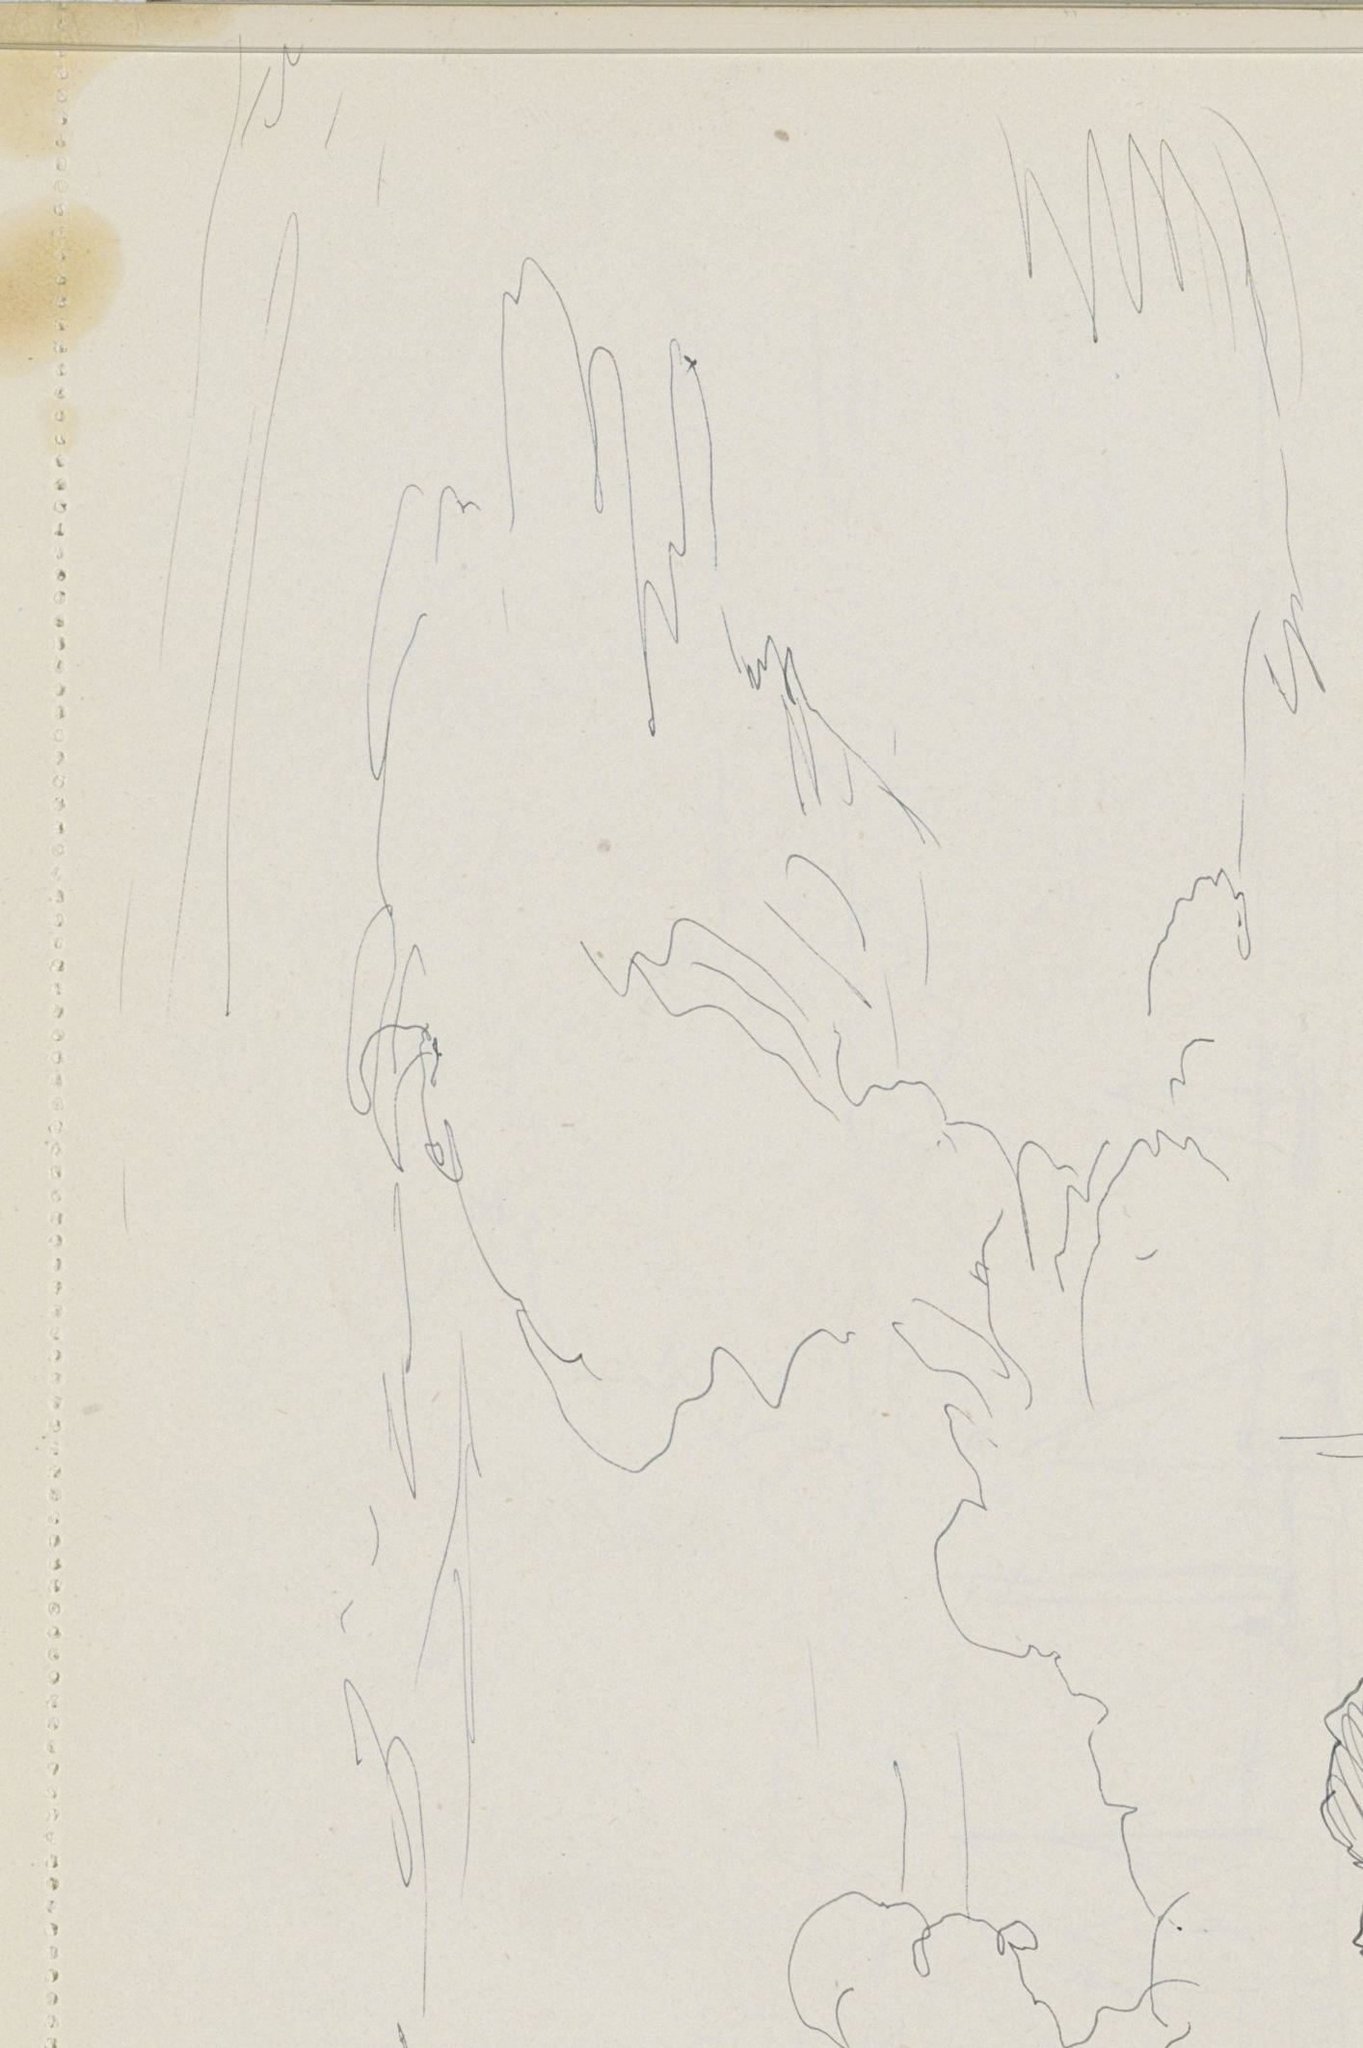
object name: sketchbook leaf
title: Zeilboten op het water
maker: cornelis vreedenburgh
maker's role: draughtsman, print maker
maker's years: 1880-1946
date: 1890-1946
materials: ink, paper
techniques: pen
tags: sailing-ship, sailing-boat, landscapes with waters, waterscapes, seascapes (in the temperate zone)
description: Blad 5 recto uit een schetsboek met uit 75 bladen.